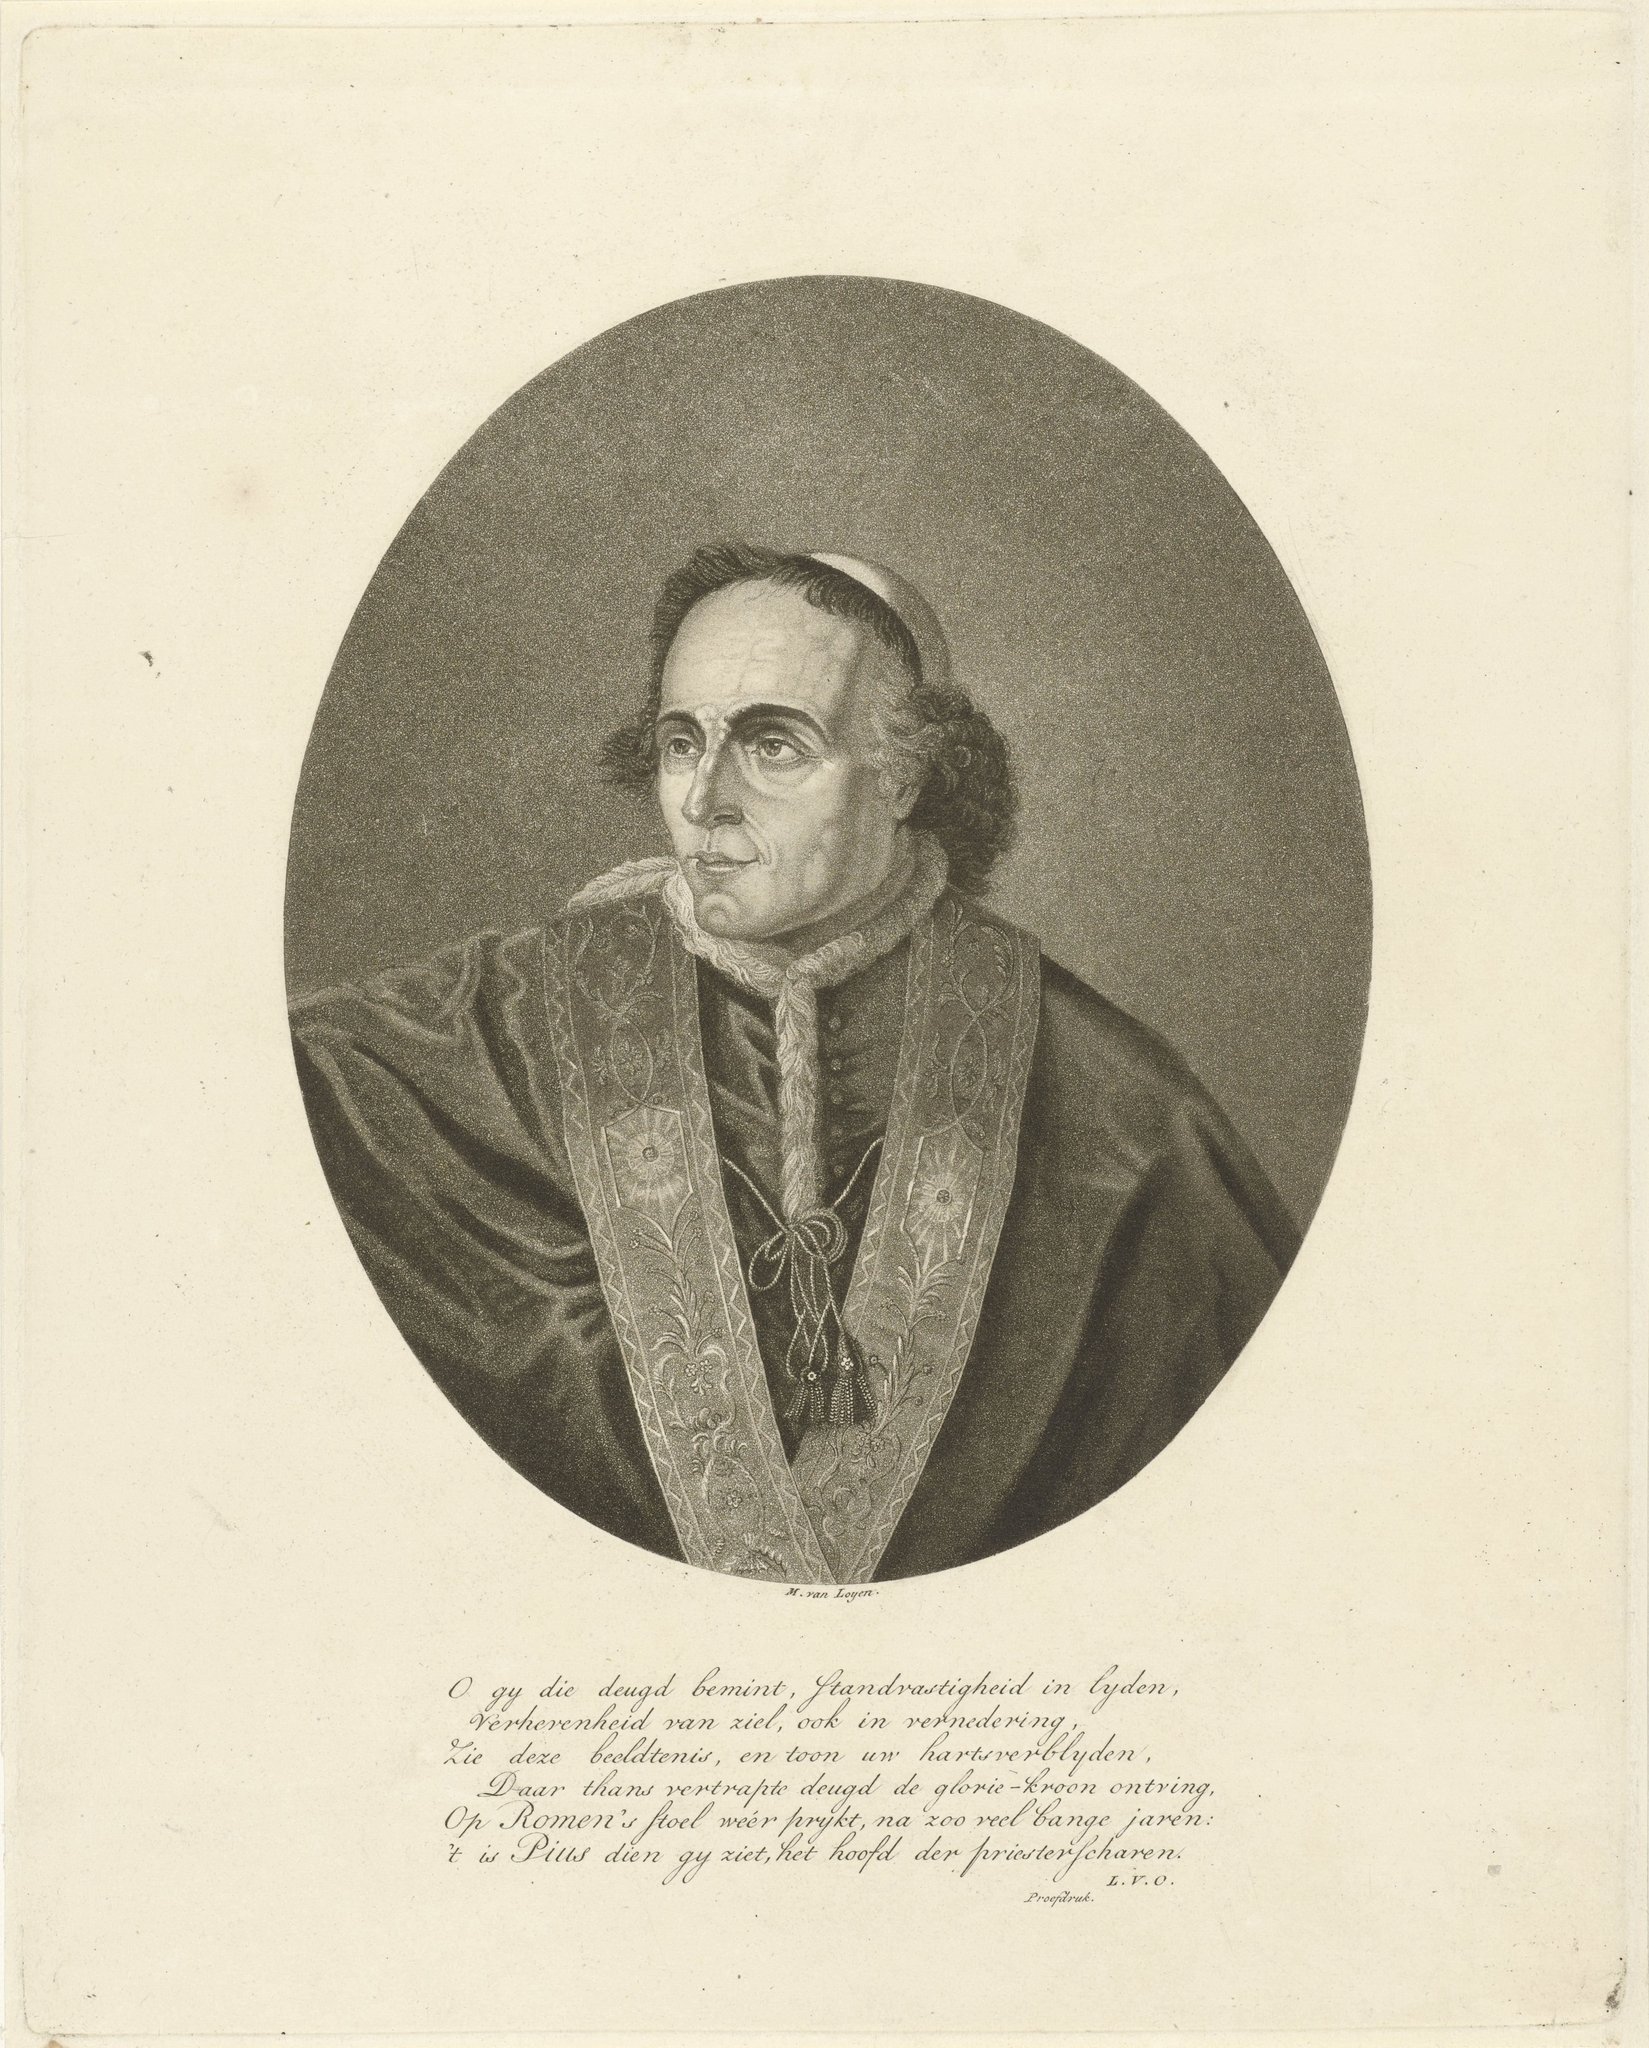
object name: print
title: Portret van Pius VII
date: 1806-1814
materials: paper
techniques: aquatint, etching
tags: rome, clergyman, pius vii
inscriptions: collector's mark: Lugt 2233